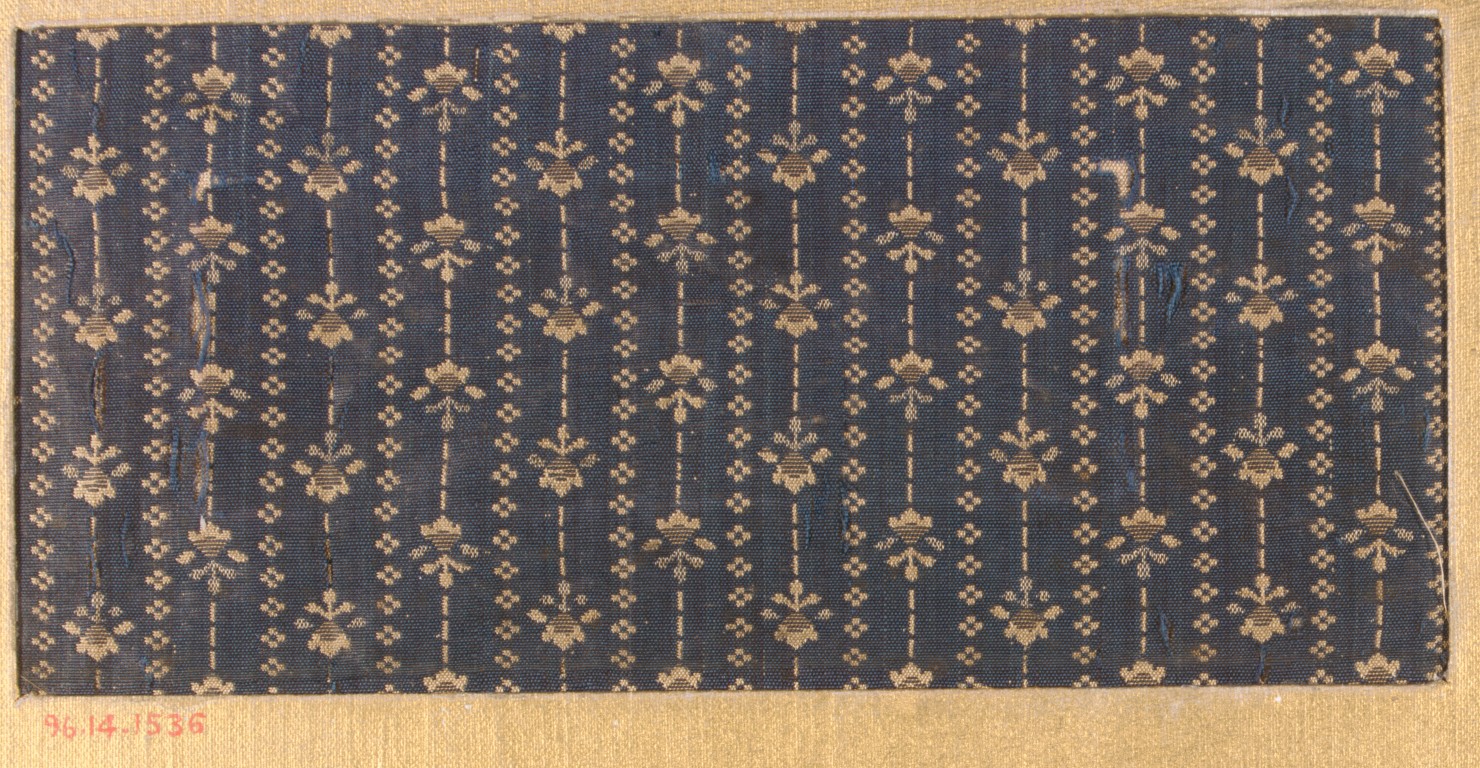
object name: piece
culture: japanese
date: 1701-1900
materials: silk